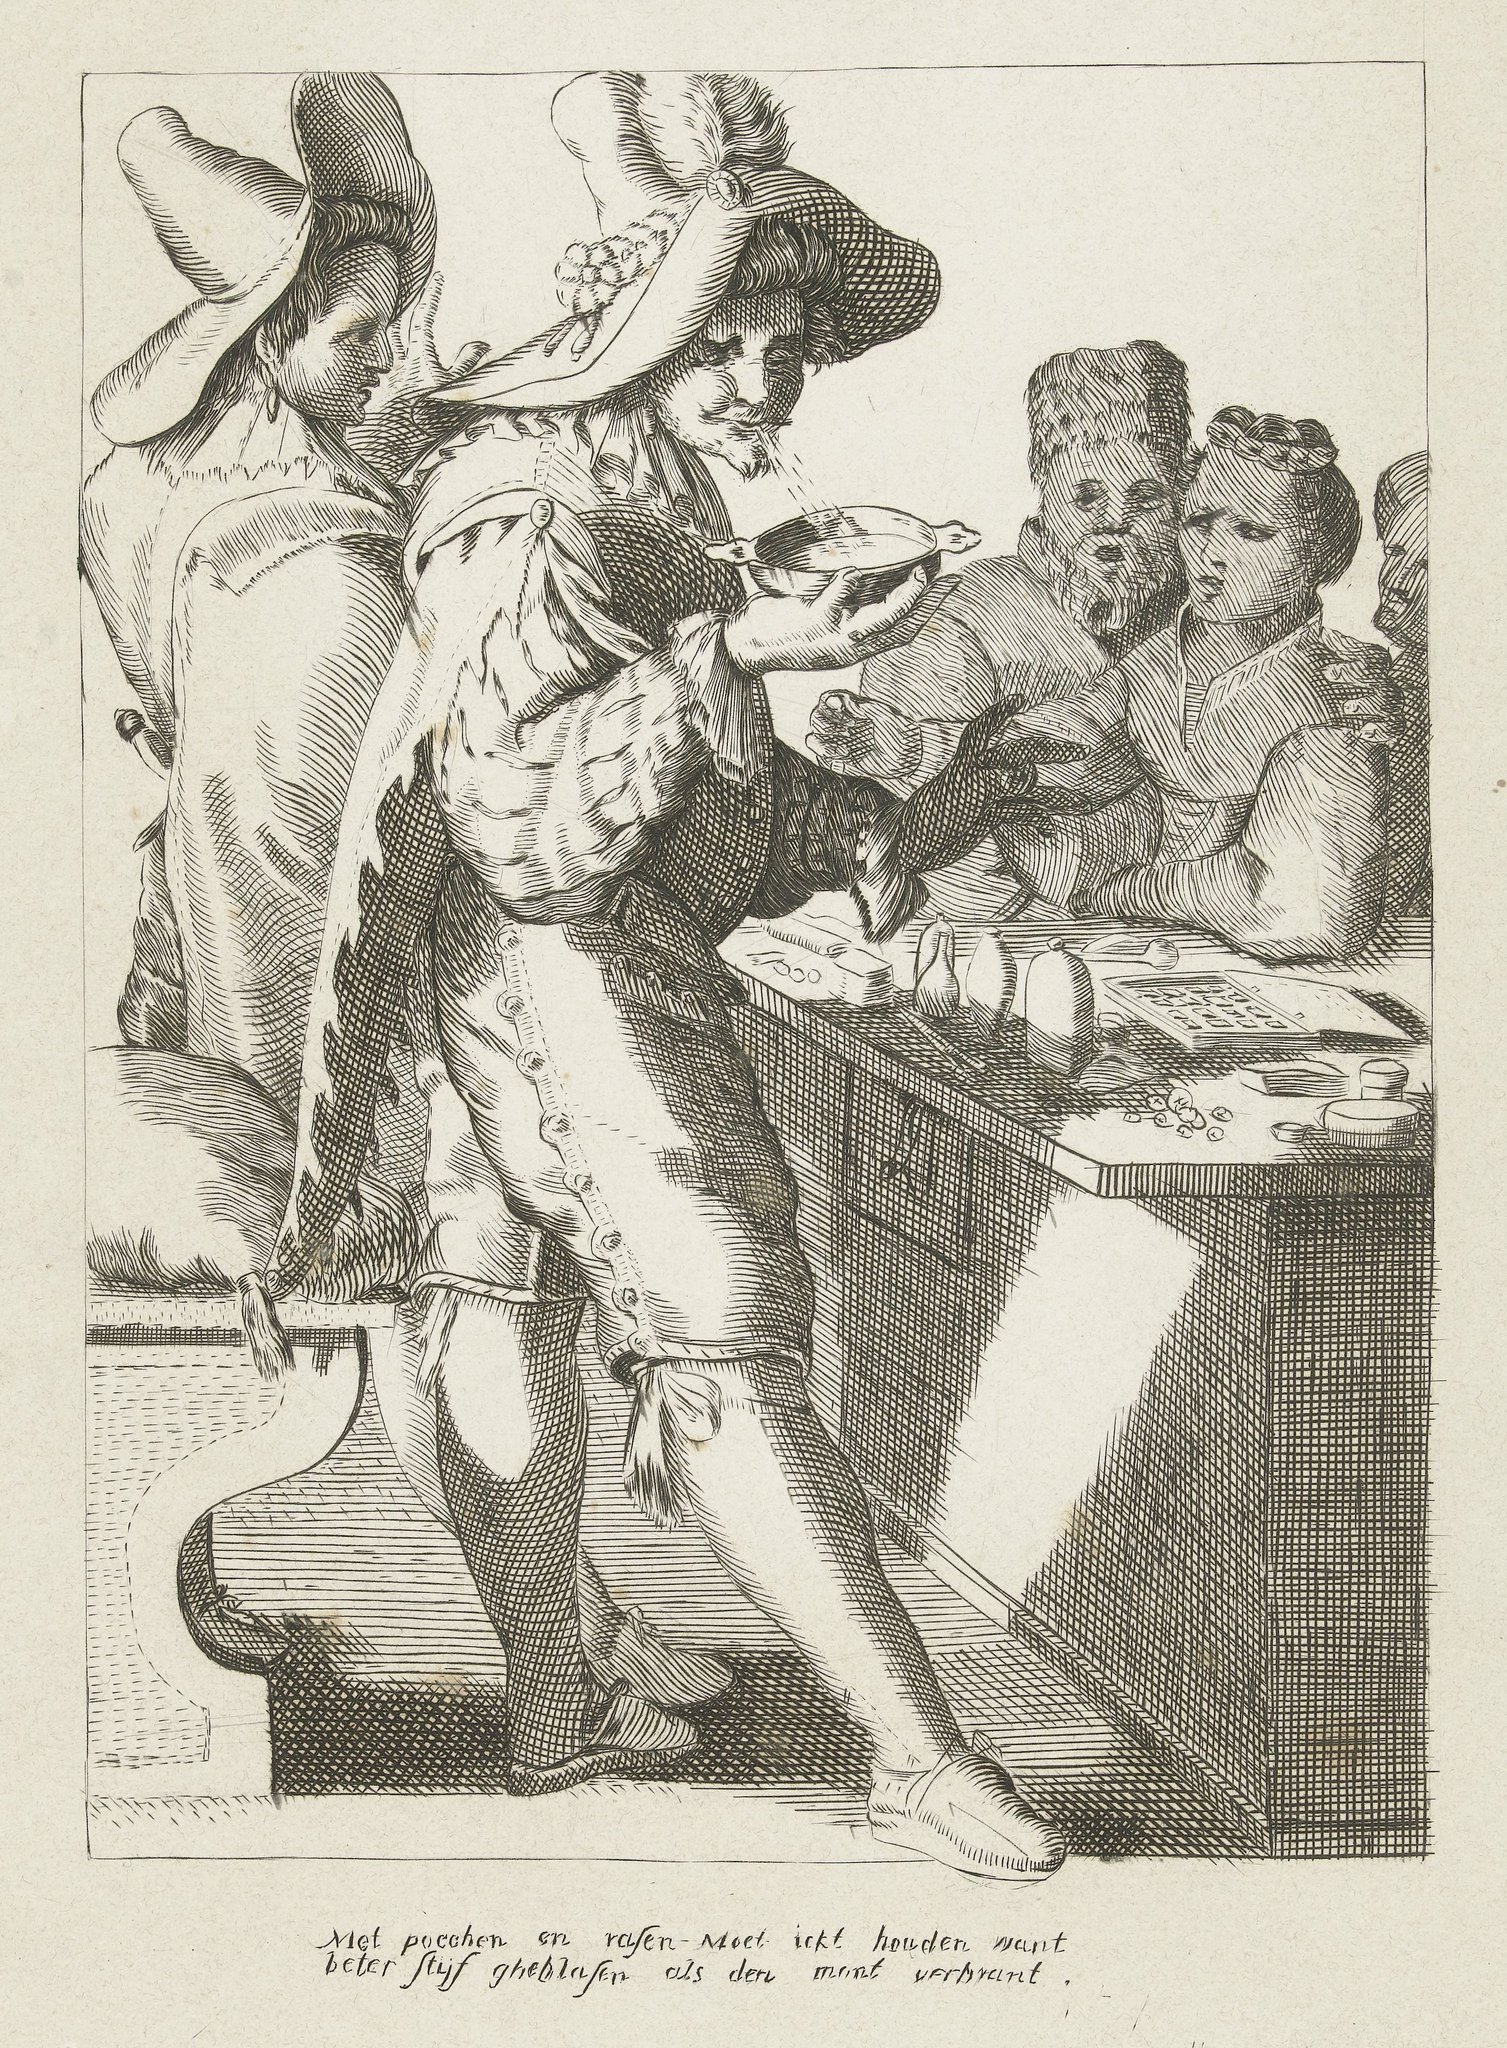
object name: print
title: Mannen en vrouwen bij toonbank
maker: a. dickhof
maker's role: print maker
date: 1860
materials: paper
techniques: engraving, etching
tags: shop, store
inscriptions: collector's mark: Lugt 2228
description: Mannen en vrouwen bij toonbank. Man spuwt een te heet gegeten gerecht weer terug in een kom. Onder Nederlands vers in twee regels.